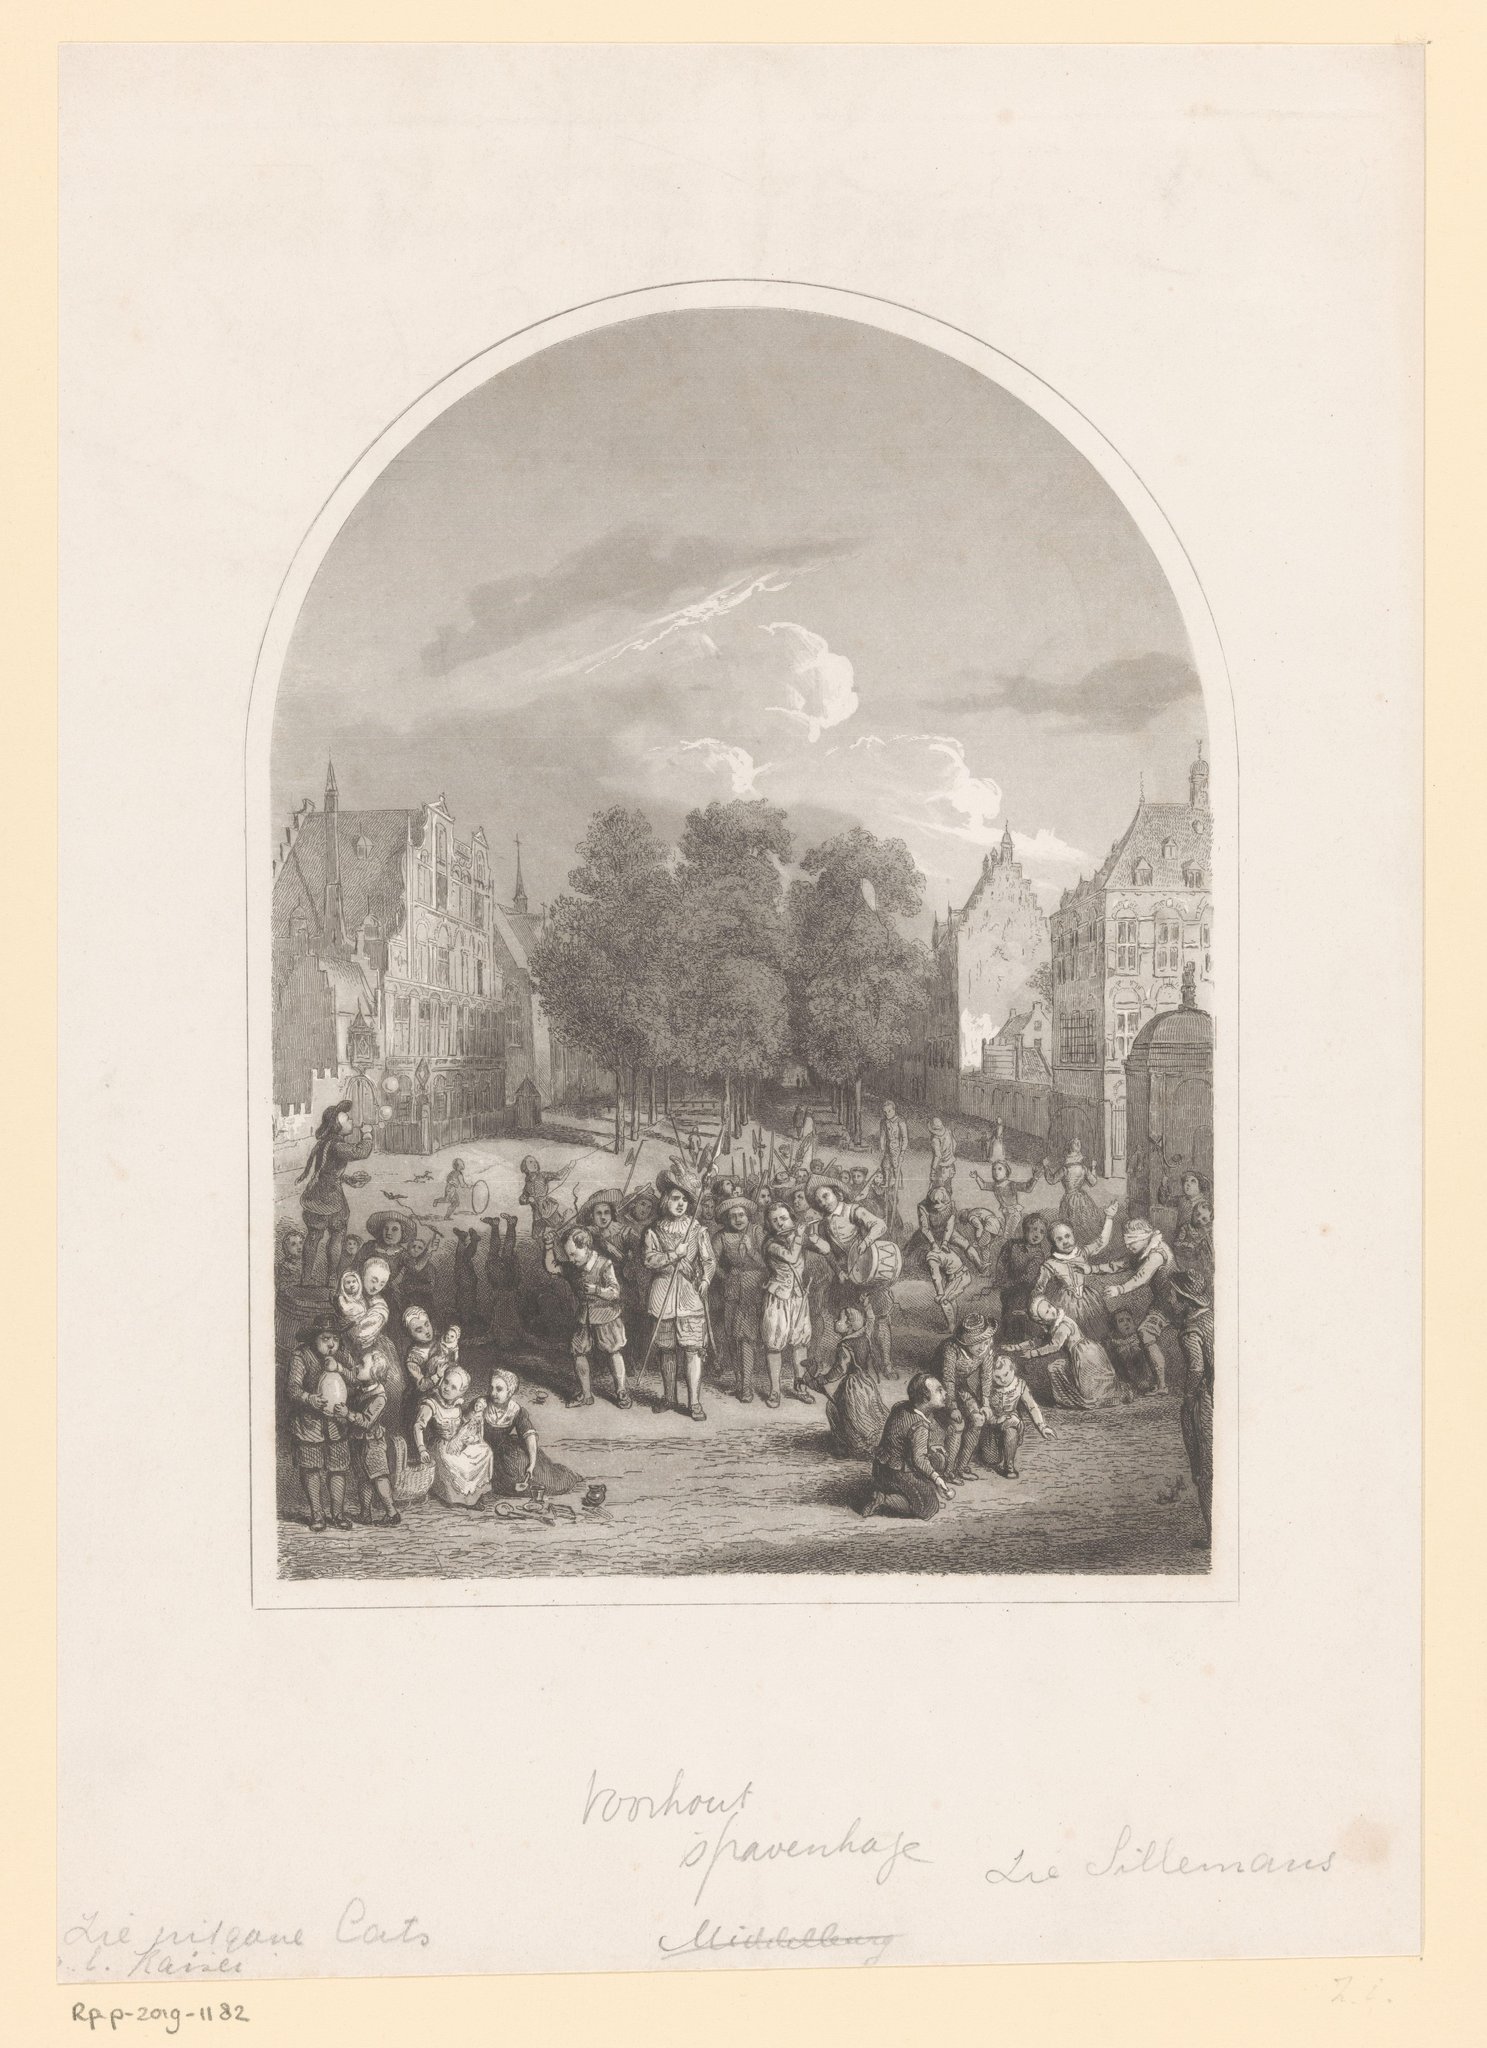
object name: print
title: Kinderspel op het Haagse Voorhout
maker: Anonymous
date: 1725-1850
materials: paper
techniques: engraving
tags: children's games and plays, playing toddler; child amusing itself, teasing (children's games and plays), street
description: Tegen de achtergrond van het Voorhout in Den Haag spelen kinderen onder andere blindemannetje, haasje over, vadertje en moedertje, touwtje springen, vliegeren en steltlopen. In het midden doet een grote groep kinderen een stoet marcherende soldaten na.